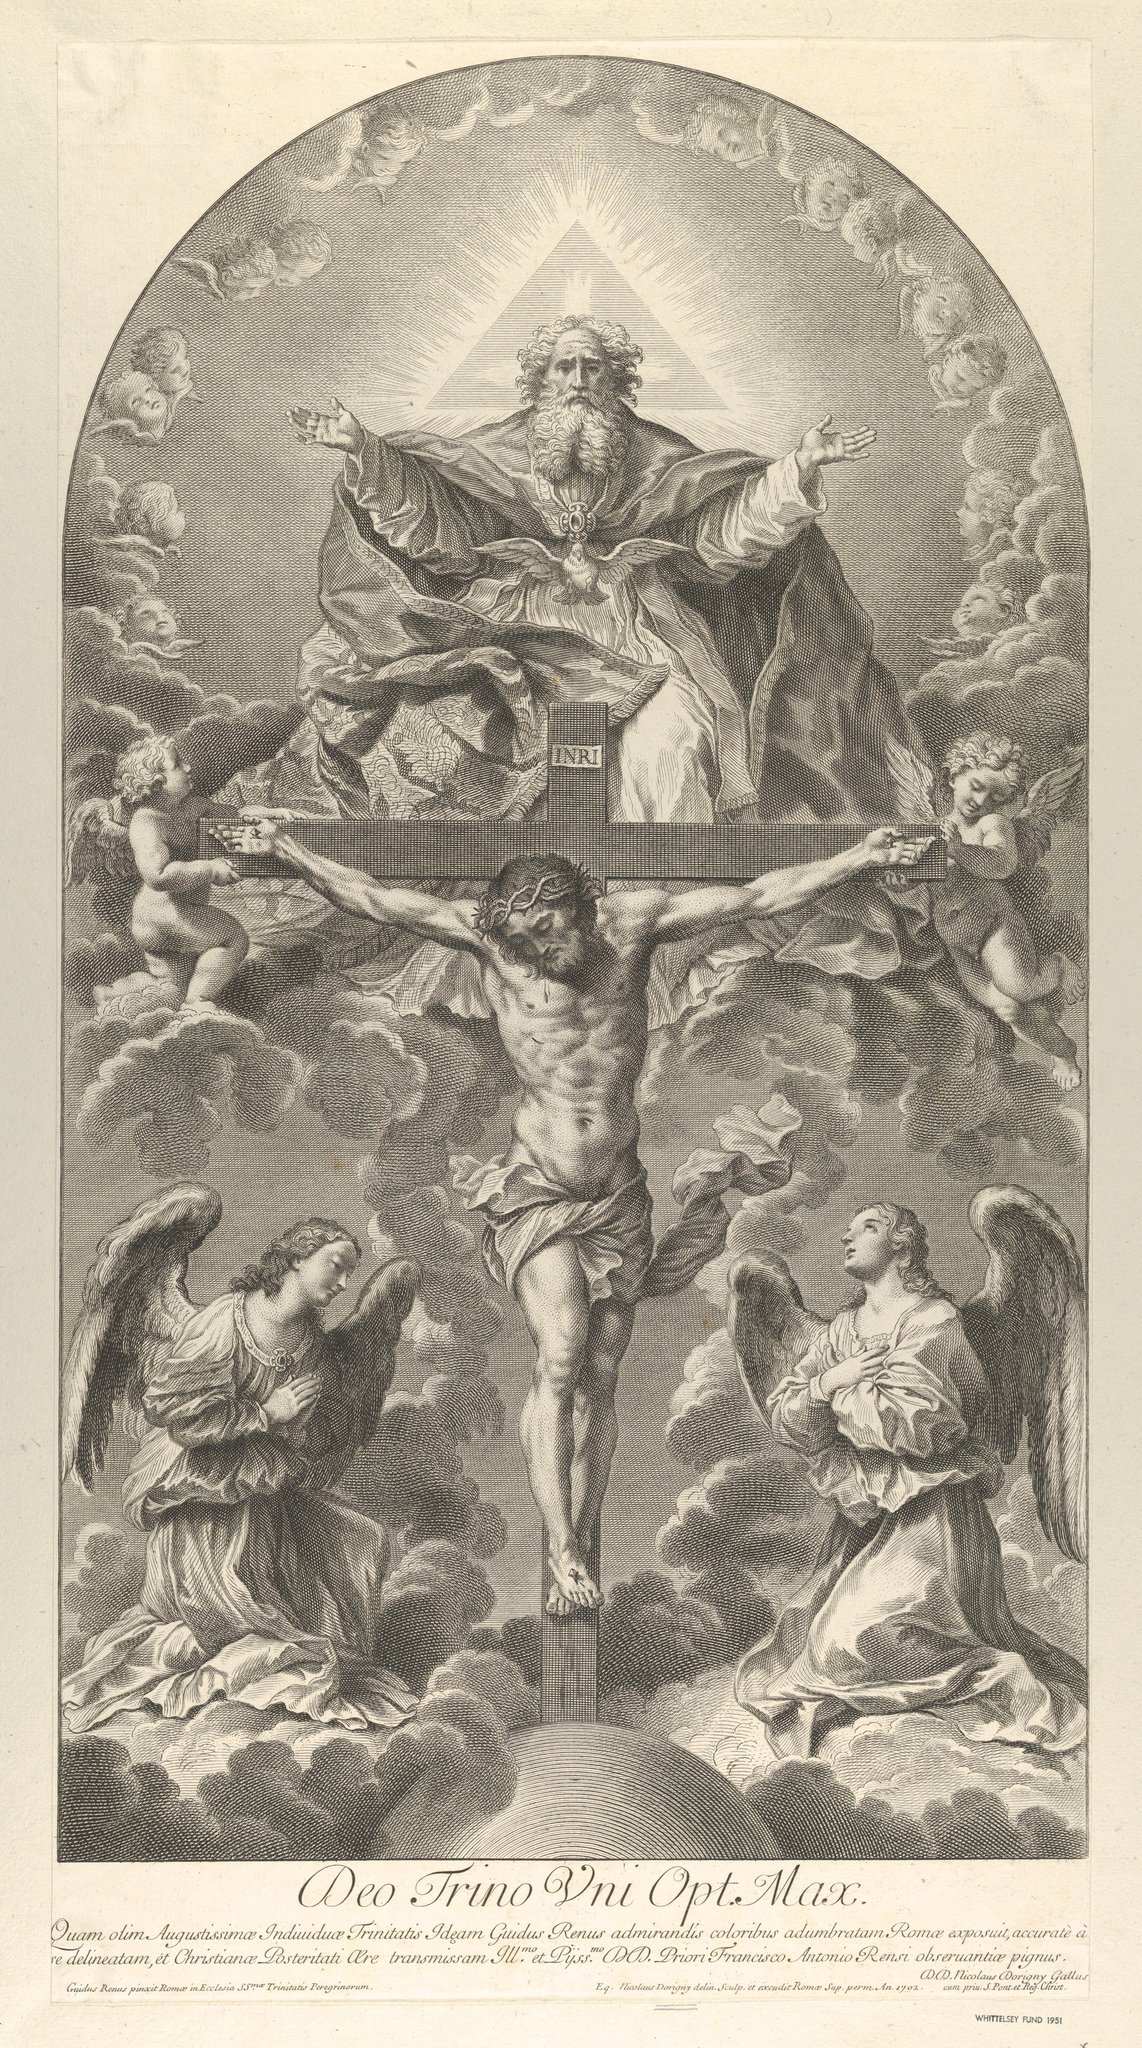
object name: print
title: The Holy Trinity; Christ on the cross flanked by two angels, the Holy Spirit as a dove and God in heaven above the cross, a rectangular composition with half-circle at the top, after Reni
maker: sir nicolas dorigny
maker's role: artist and publisher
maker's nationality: french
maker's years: 1655-1746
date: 1702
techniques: engraving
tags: angels,christ,cross,crucifixion